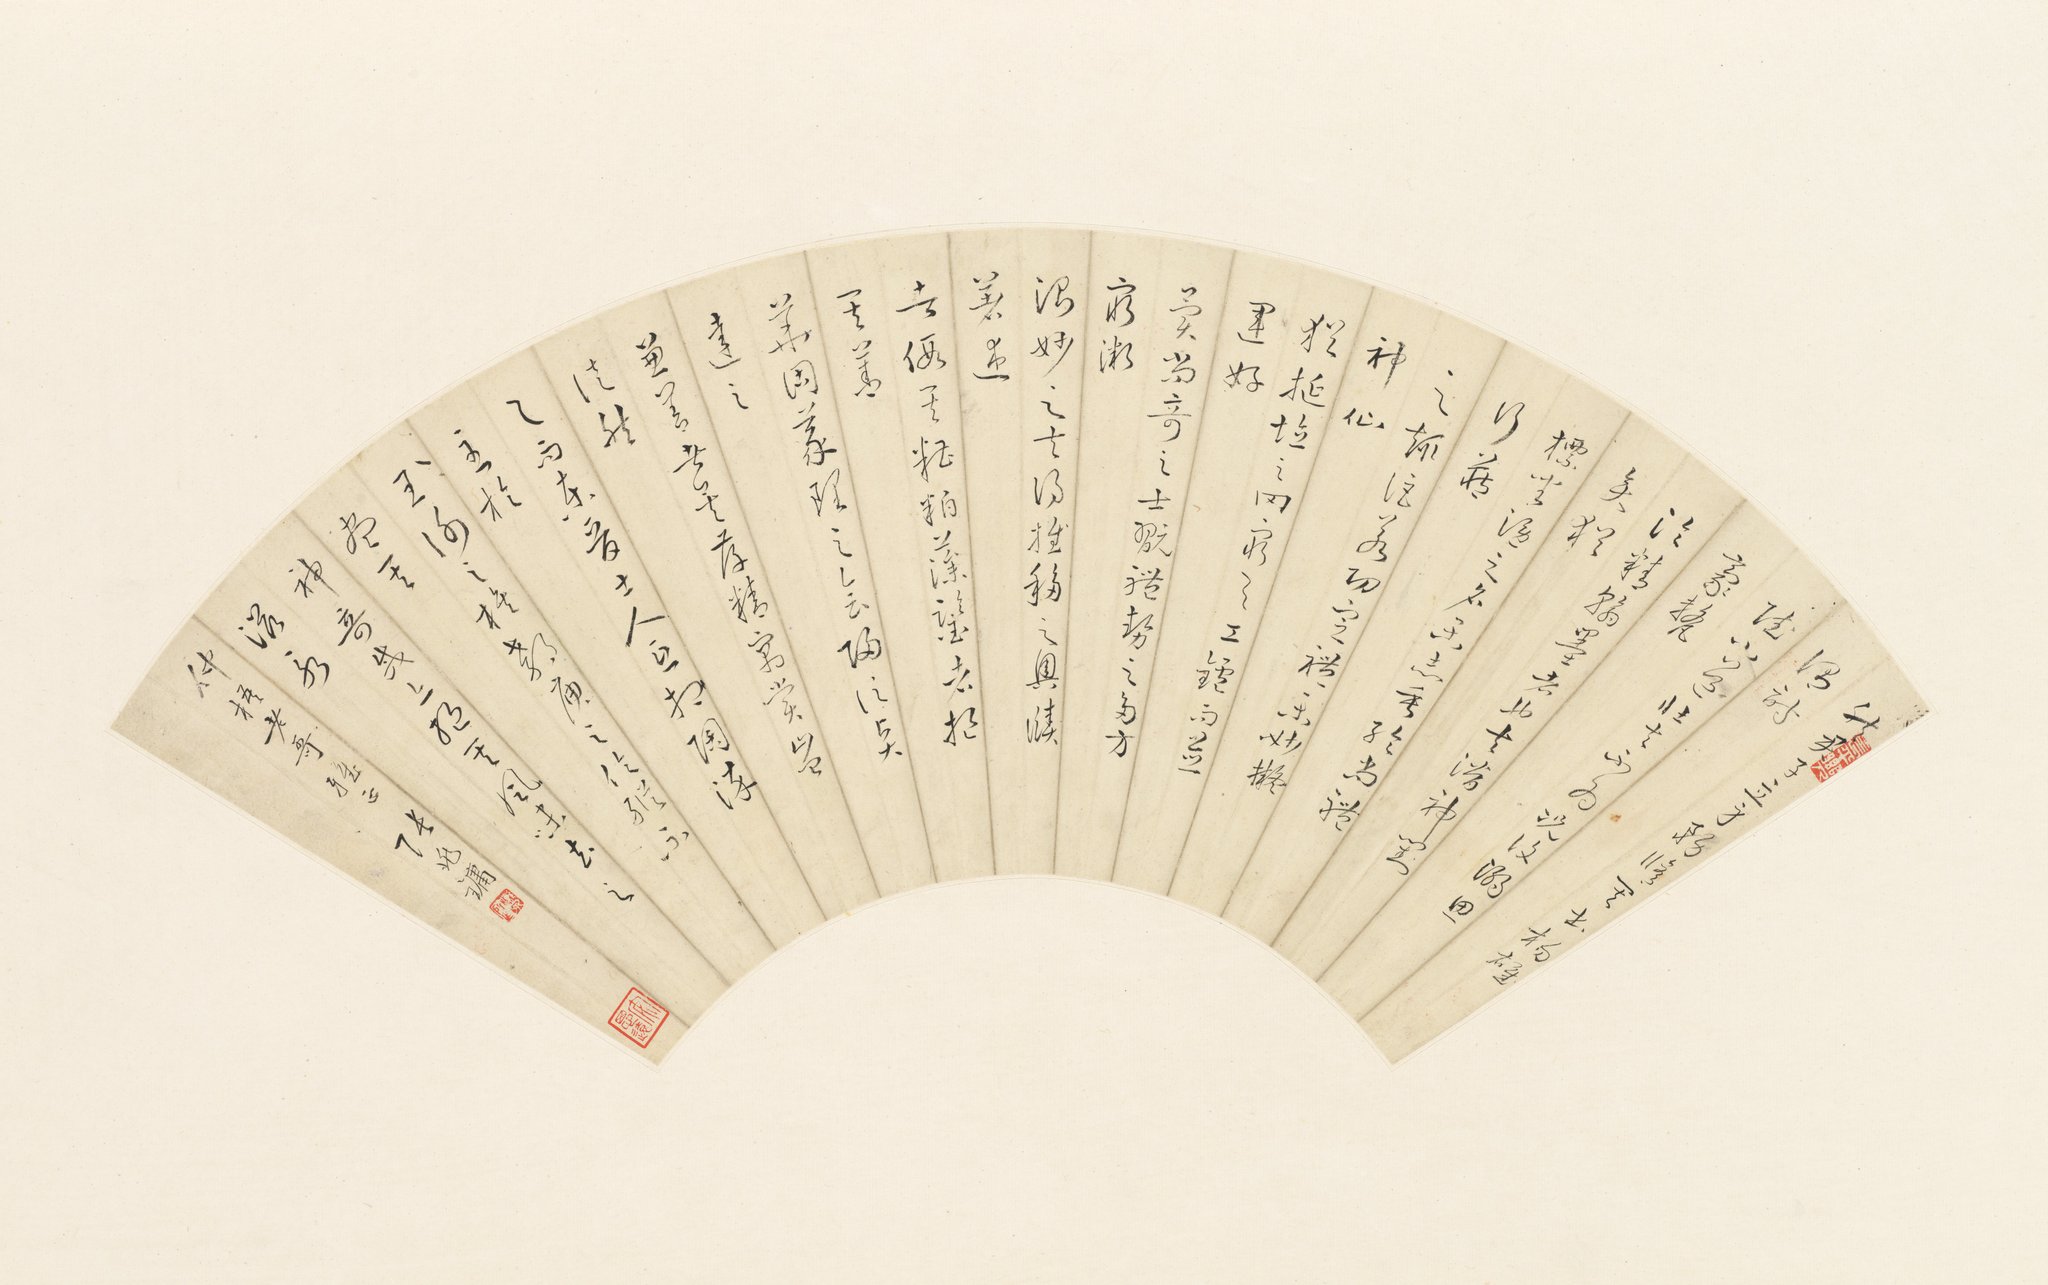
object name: folding fan mounted a an album leaf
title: Calligraphy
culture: chinese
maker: zhang zhaoyong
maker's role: artist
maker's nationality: chinese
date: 1901-2000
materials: ink, paper